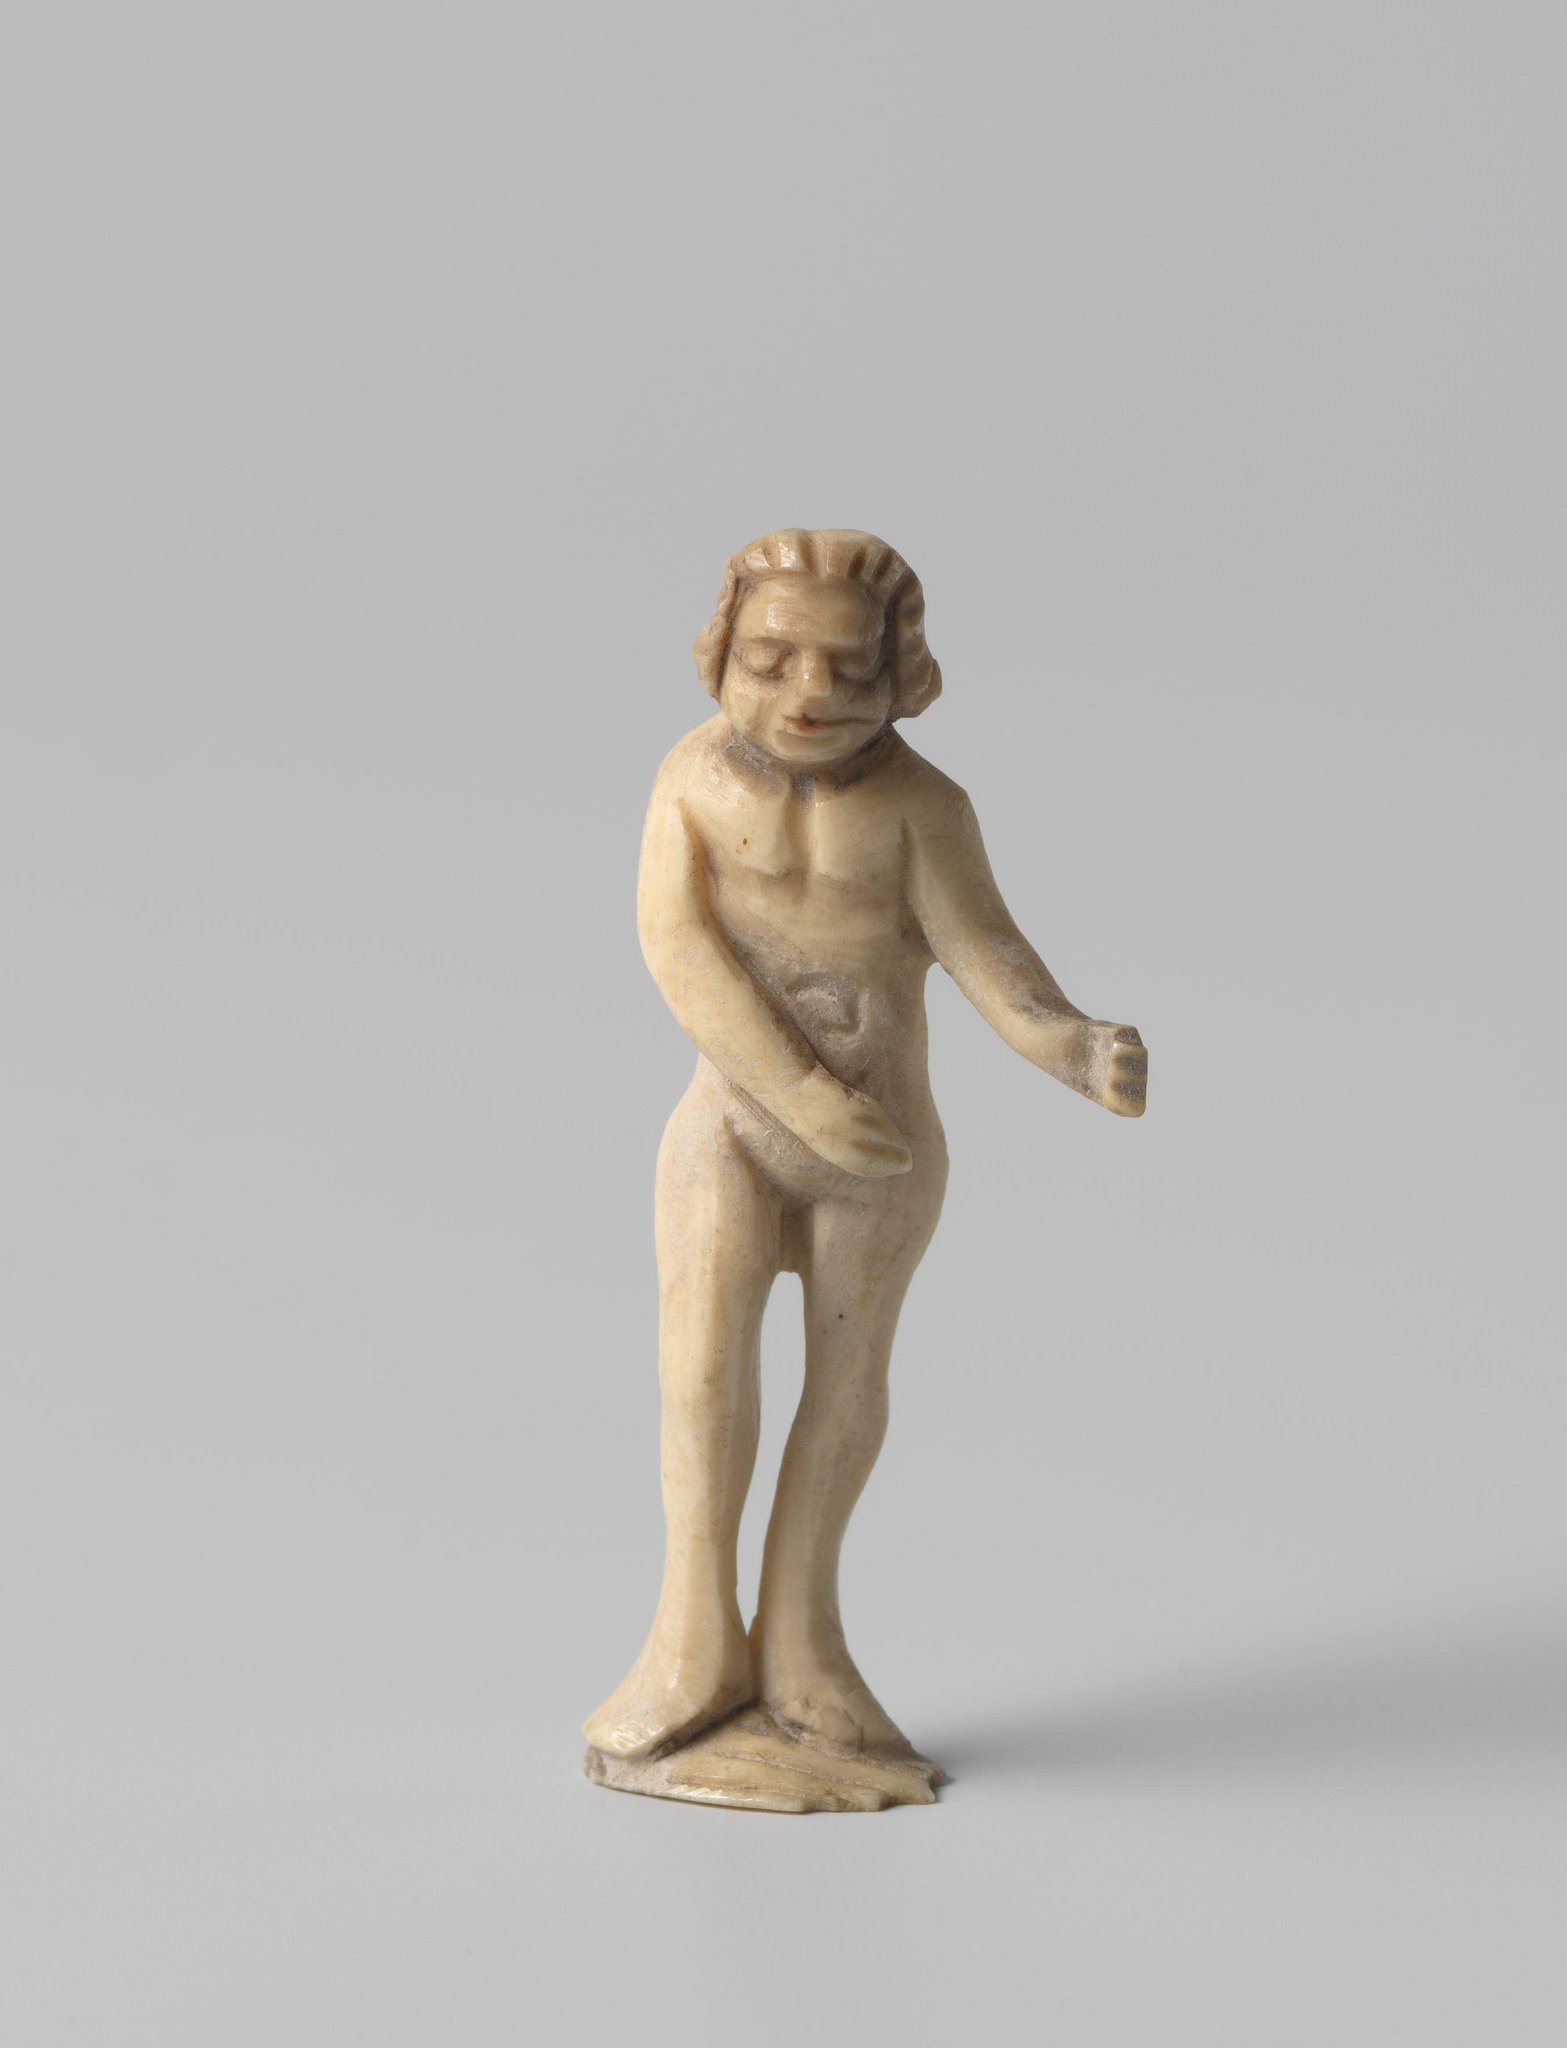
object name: sculpture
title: Naakt mansbeeld.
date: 1400-1950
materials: bone